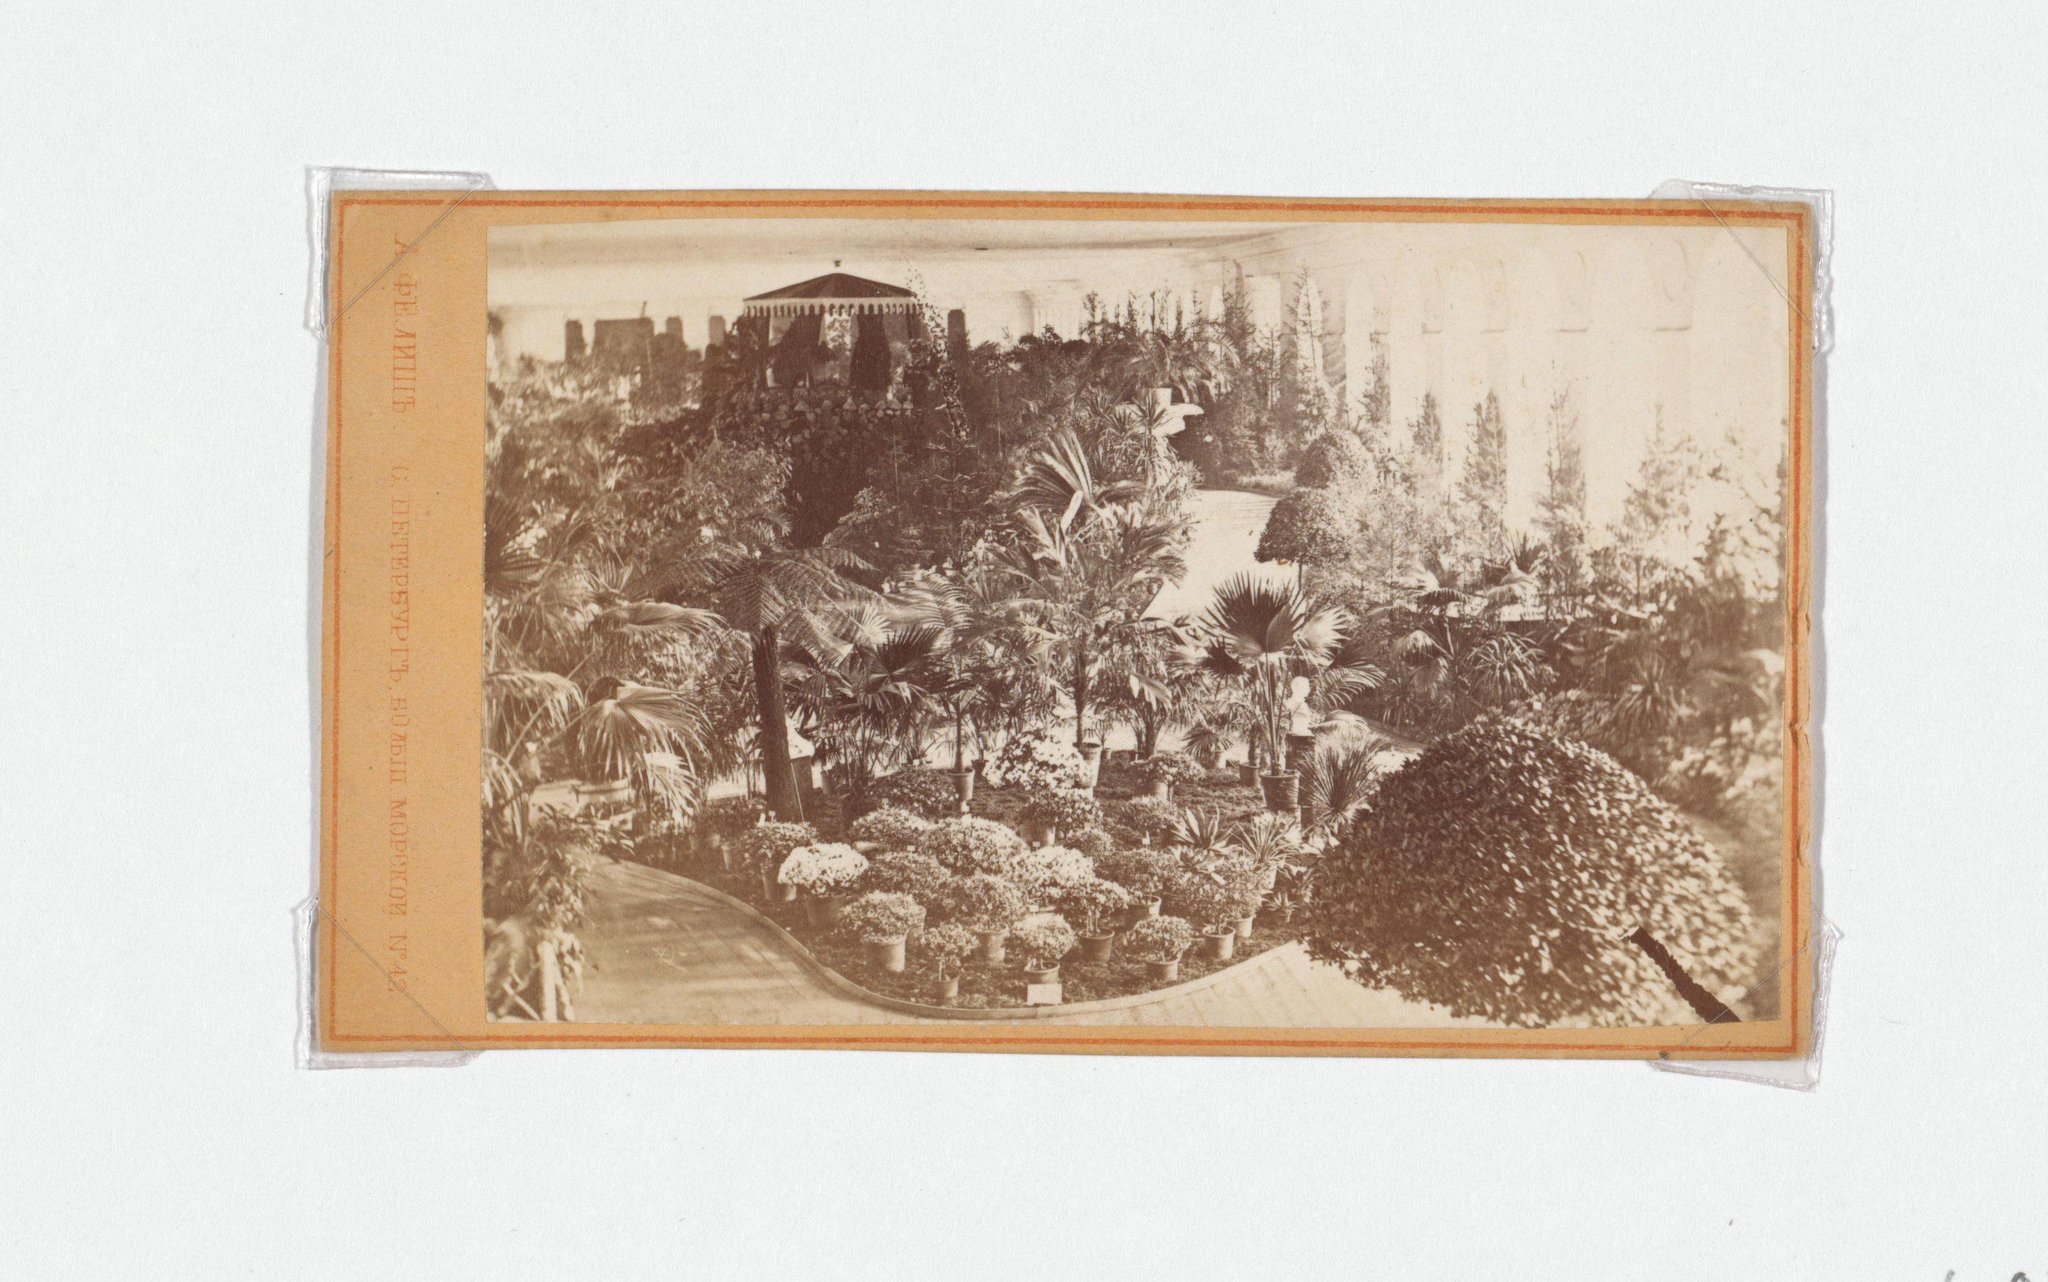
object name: photograph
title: Plantentuin, mogelijk in Sint Petersburg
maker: albert felisch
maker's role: fotograaf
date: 1880-1900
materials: cardboard, paper, photographic support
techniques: albumen print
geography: sint-petersburg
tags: botanic garden, 'hortus botanicus'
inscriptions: address: ‘Sint Petersburg Bol’shaja Morskaja No. 42’